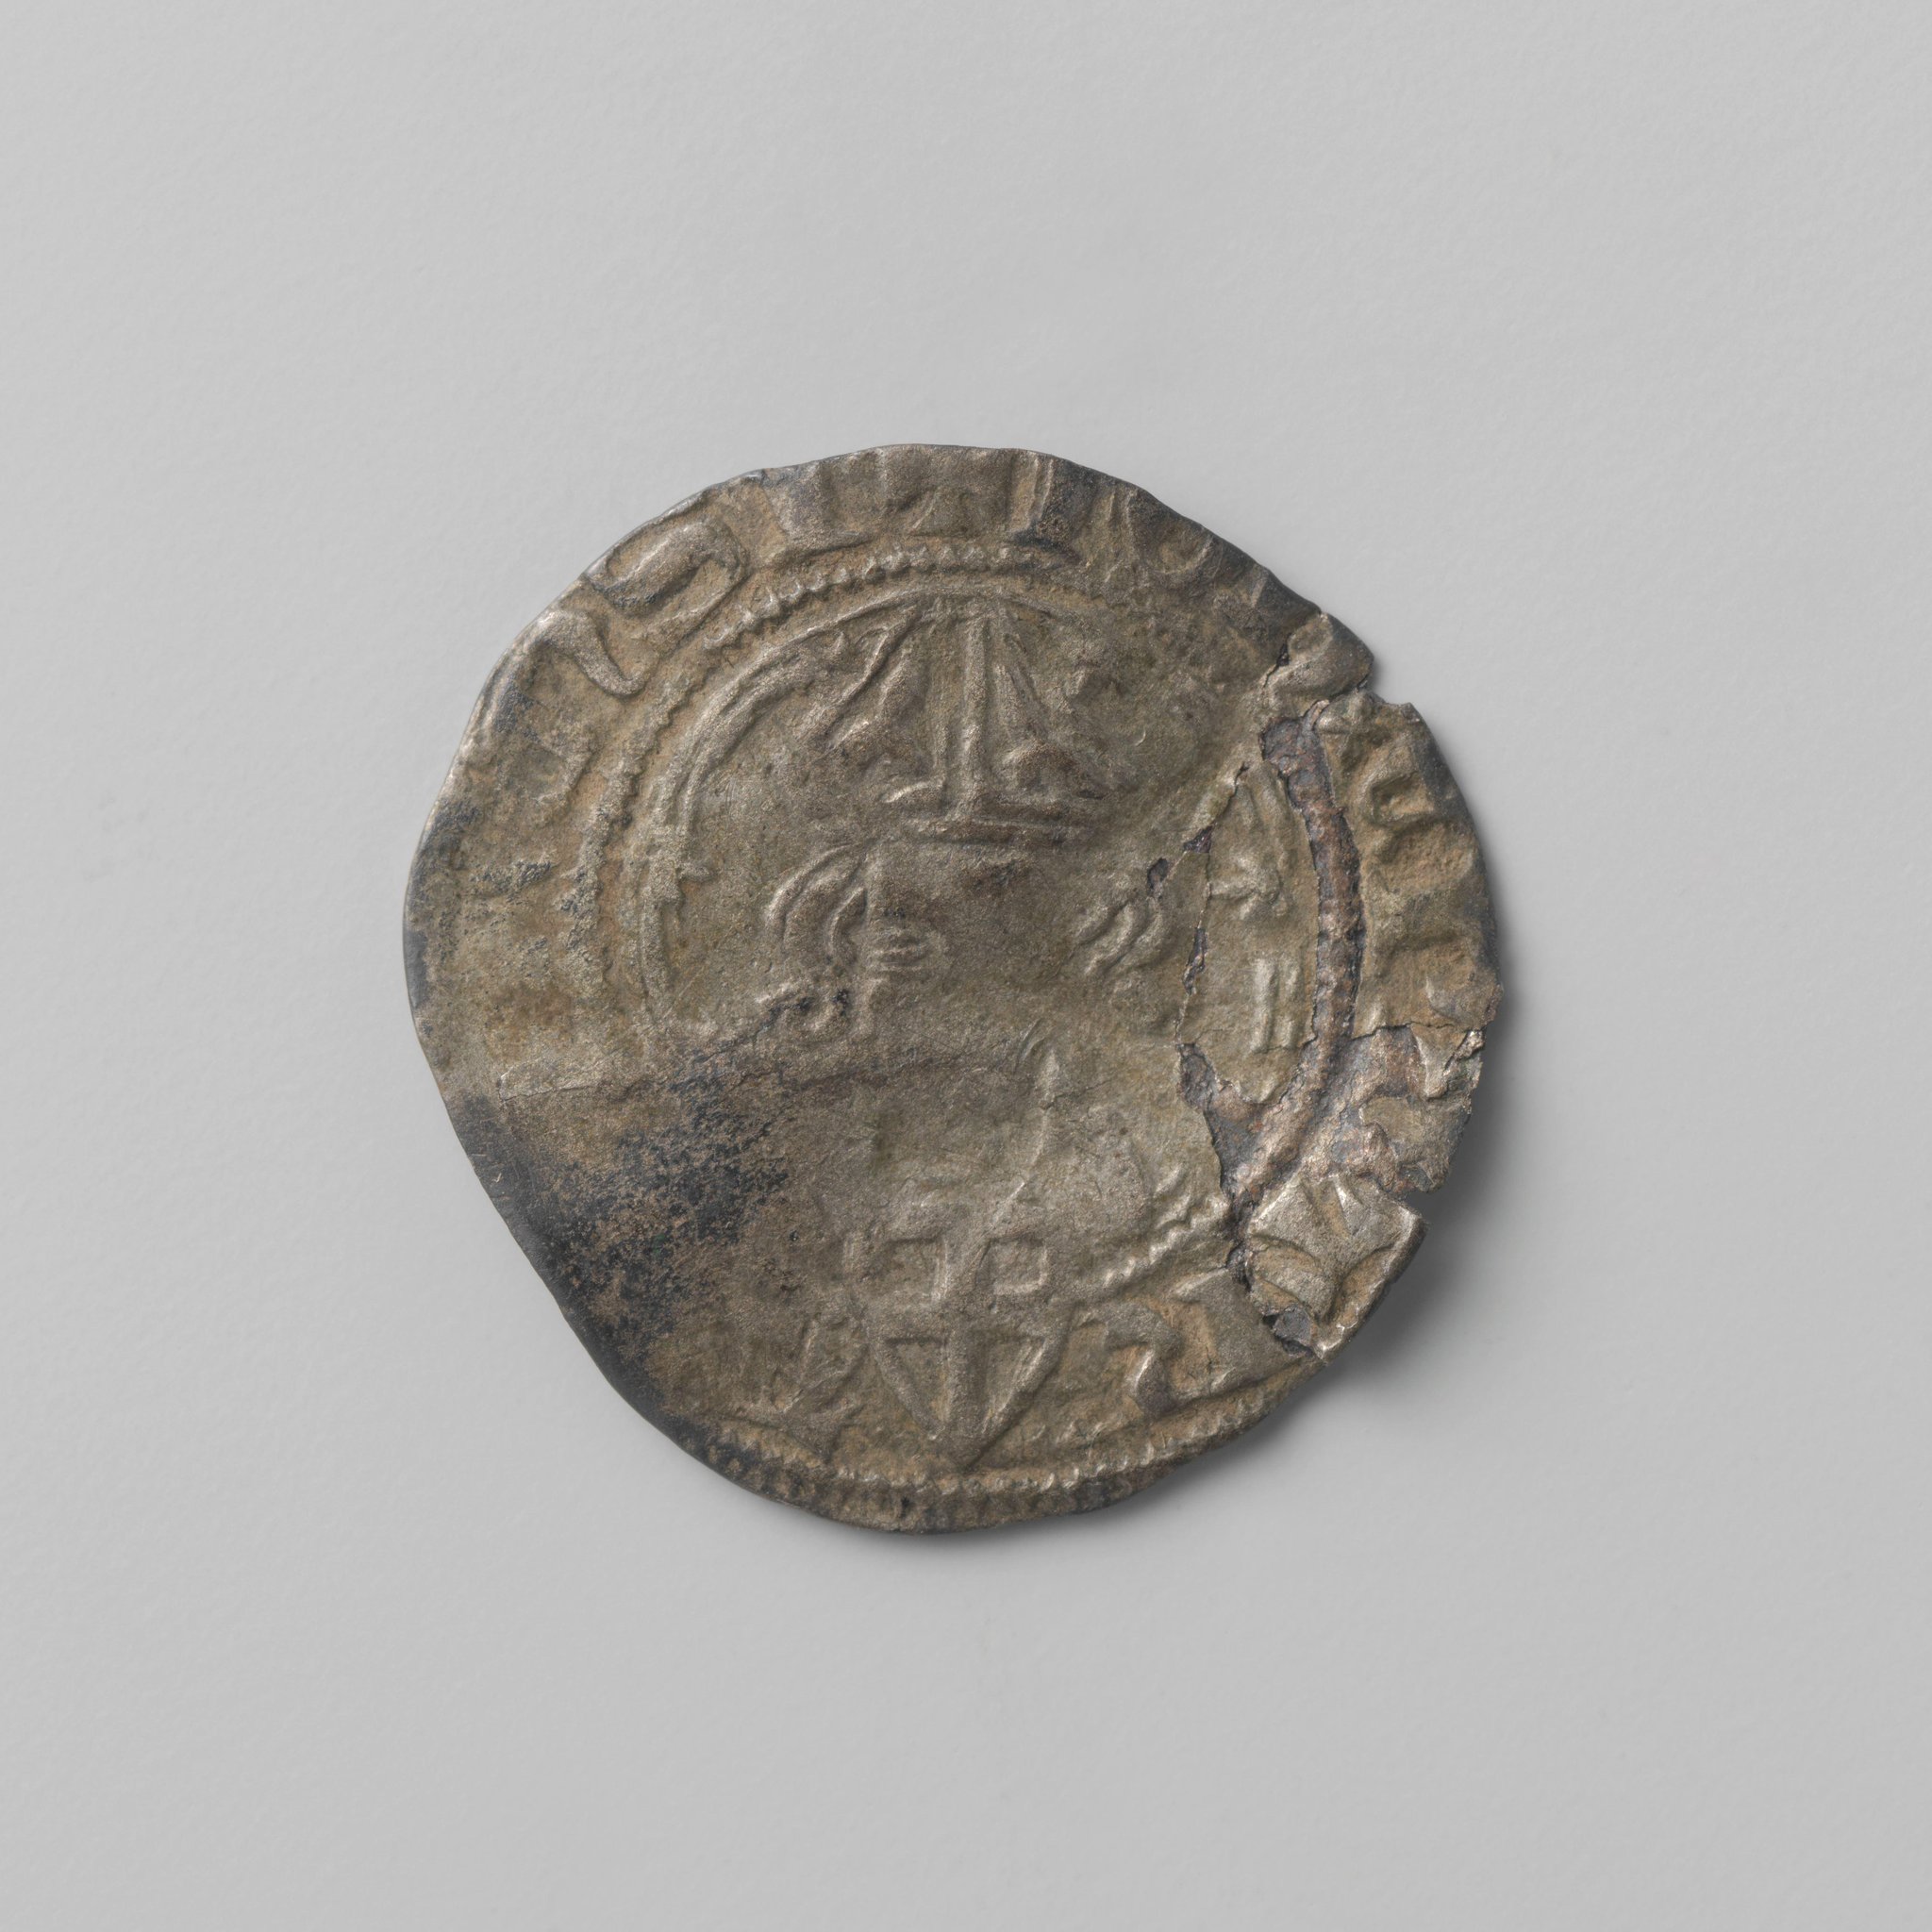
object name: coin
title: Utrecht, Jan van Verneburg, halve groot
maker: jan van verneburg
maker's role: bisschop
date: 1364-1371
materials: silver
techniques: striking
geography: vollenhove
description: Voorzijde: binnen versierde veelpas aanziend portret van de bisschop met mijter met voor zich wapenschild van Verneburg. Keerzijde: halflang gevoet kruis. Dubbel omschrift. Buiten: MONETA VOLEHO TRAIECT, binnen: IN-OI-ED-NI [in nomine domini]